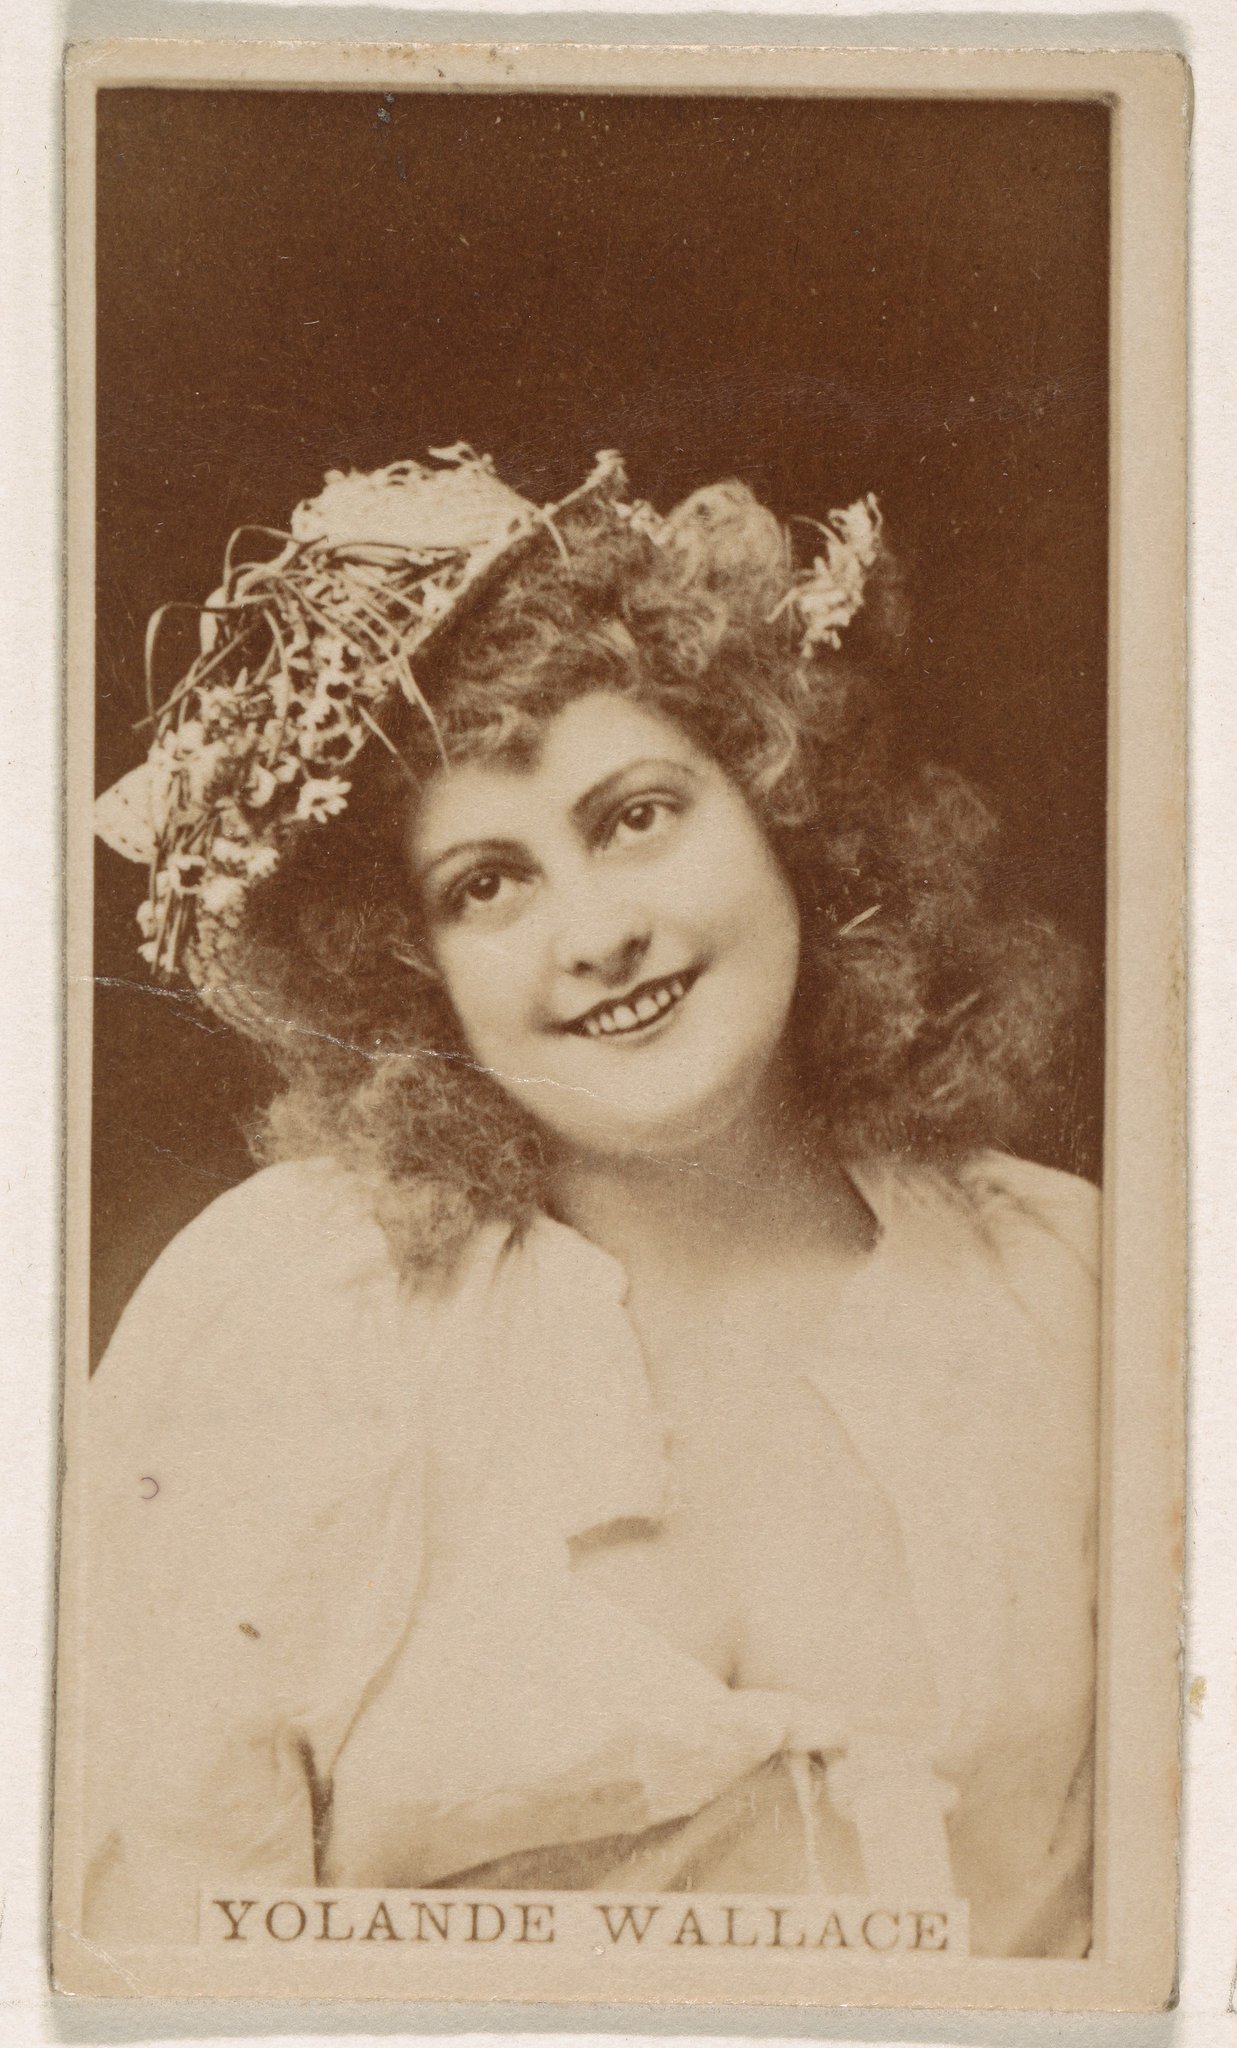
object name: photograph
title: Yolande Wallace, from the Actresses series (N245) issued by Kinney Brothers to promote Sweet Caporal Cigarettes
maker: kinney brothers tobacco company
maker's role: publisher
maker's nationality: american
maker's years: 1869-2011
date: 1890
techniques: albumen silver print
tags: portraits,women,actresses